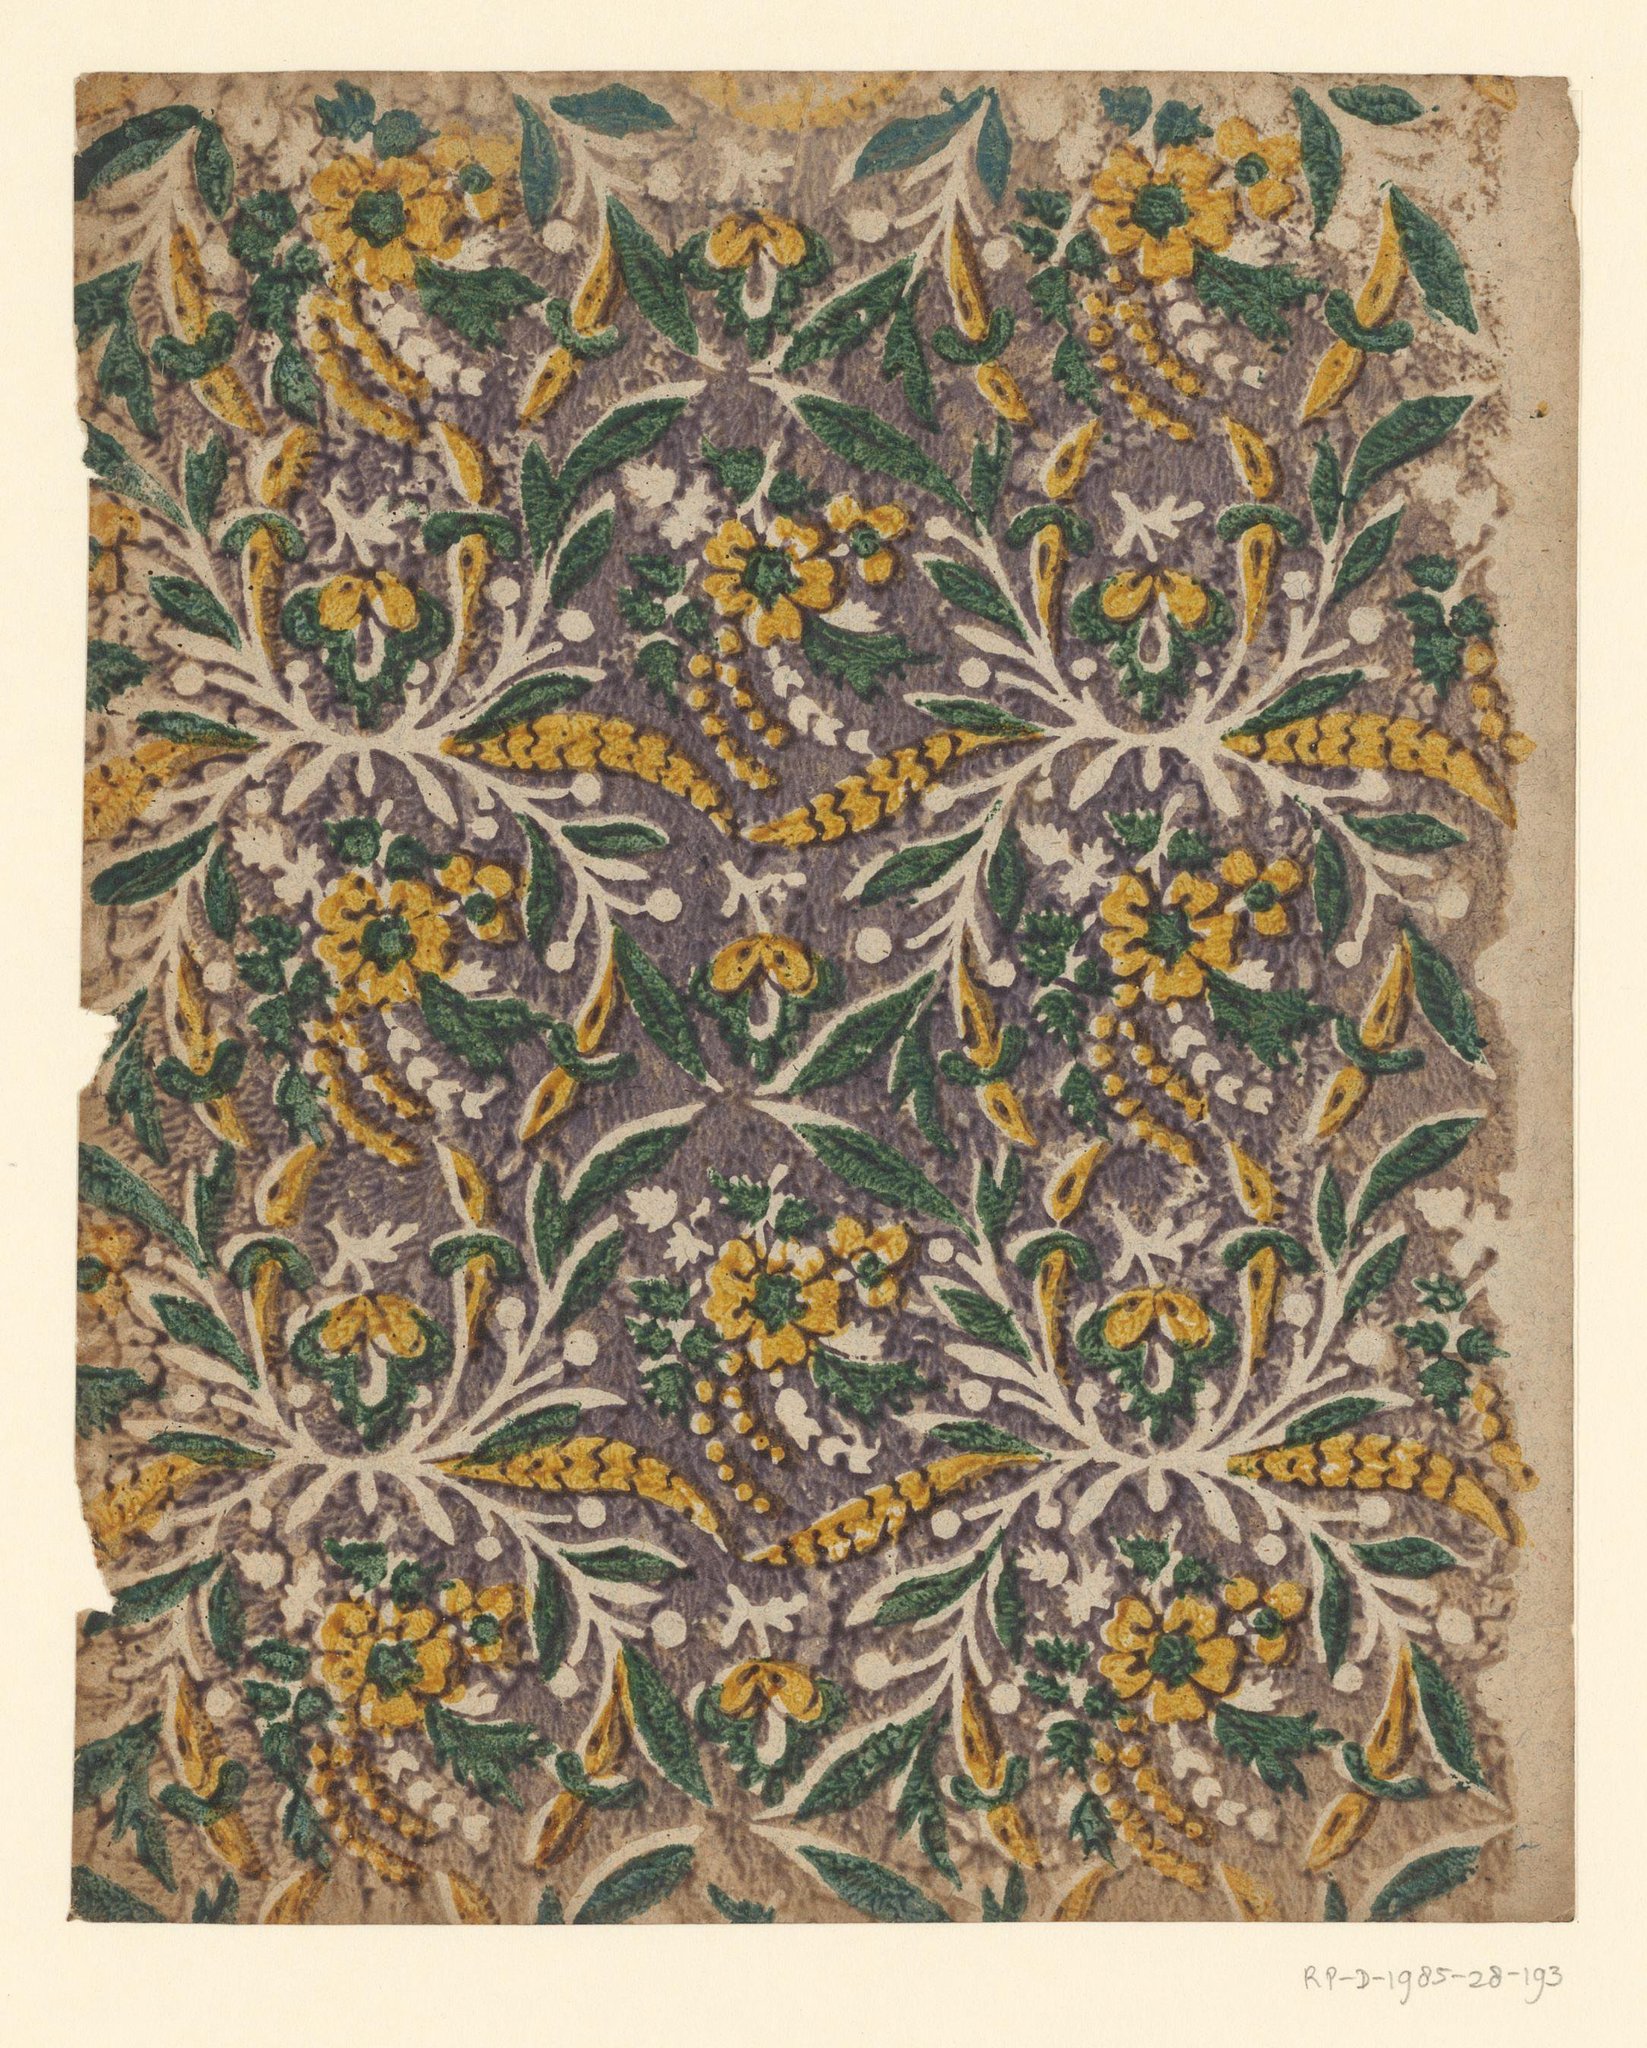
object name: printed paper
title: Blad met strooipatroon van bladeren met bloemen en vruchten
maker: Anonymous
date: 1750-1900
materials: paper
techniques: printing block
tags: ornament derived from plant forms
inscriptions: collector's mark: Lugt 2228, collector's mark: Lugt 2760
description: Blad met strooipatroon van bladeren met bloemen en vruchten en uitgespaarde ranken. Helft van een omslag.